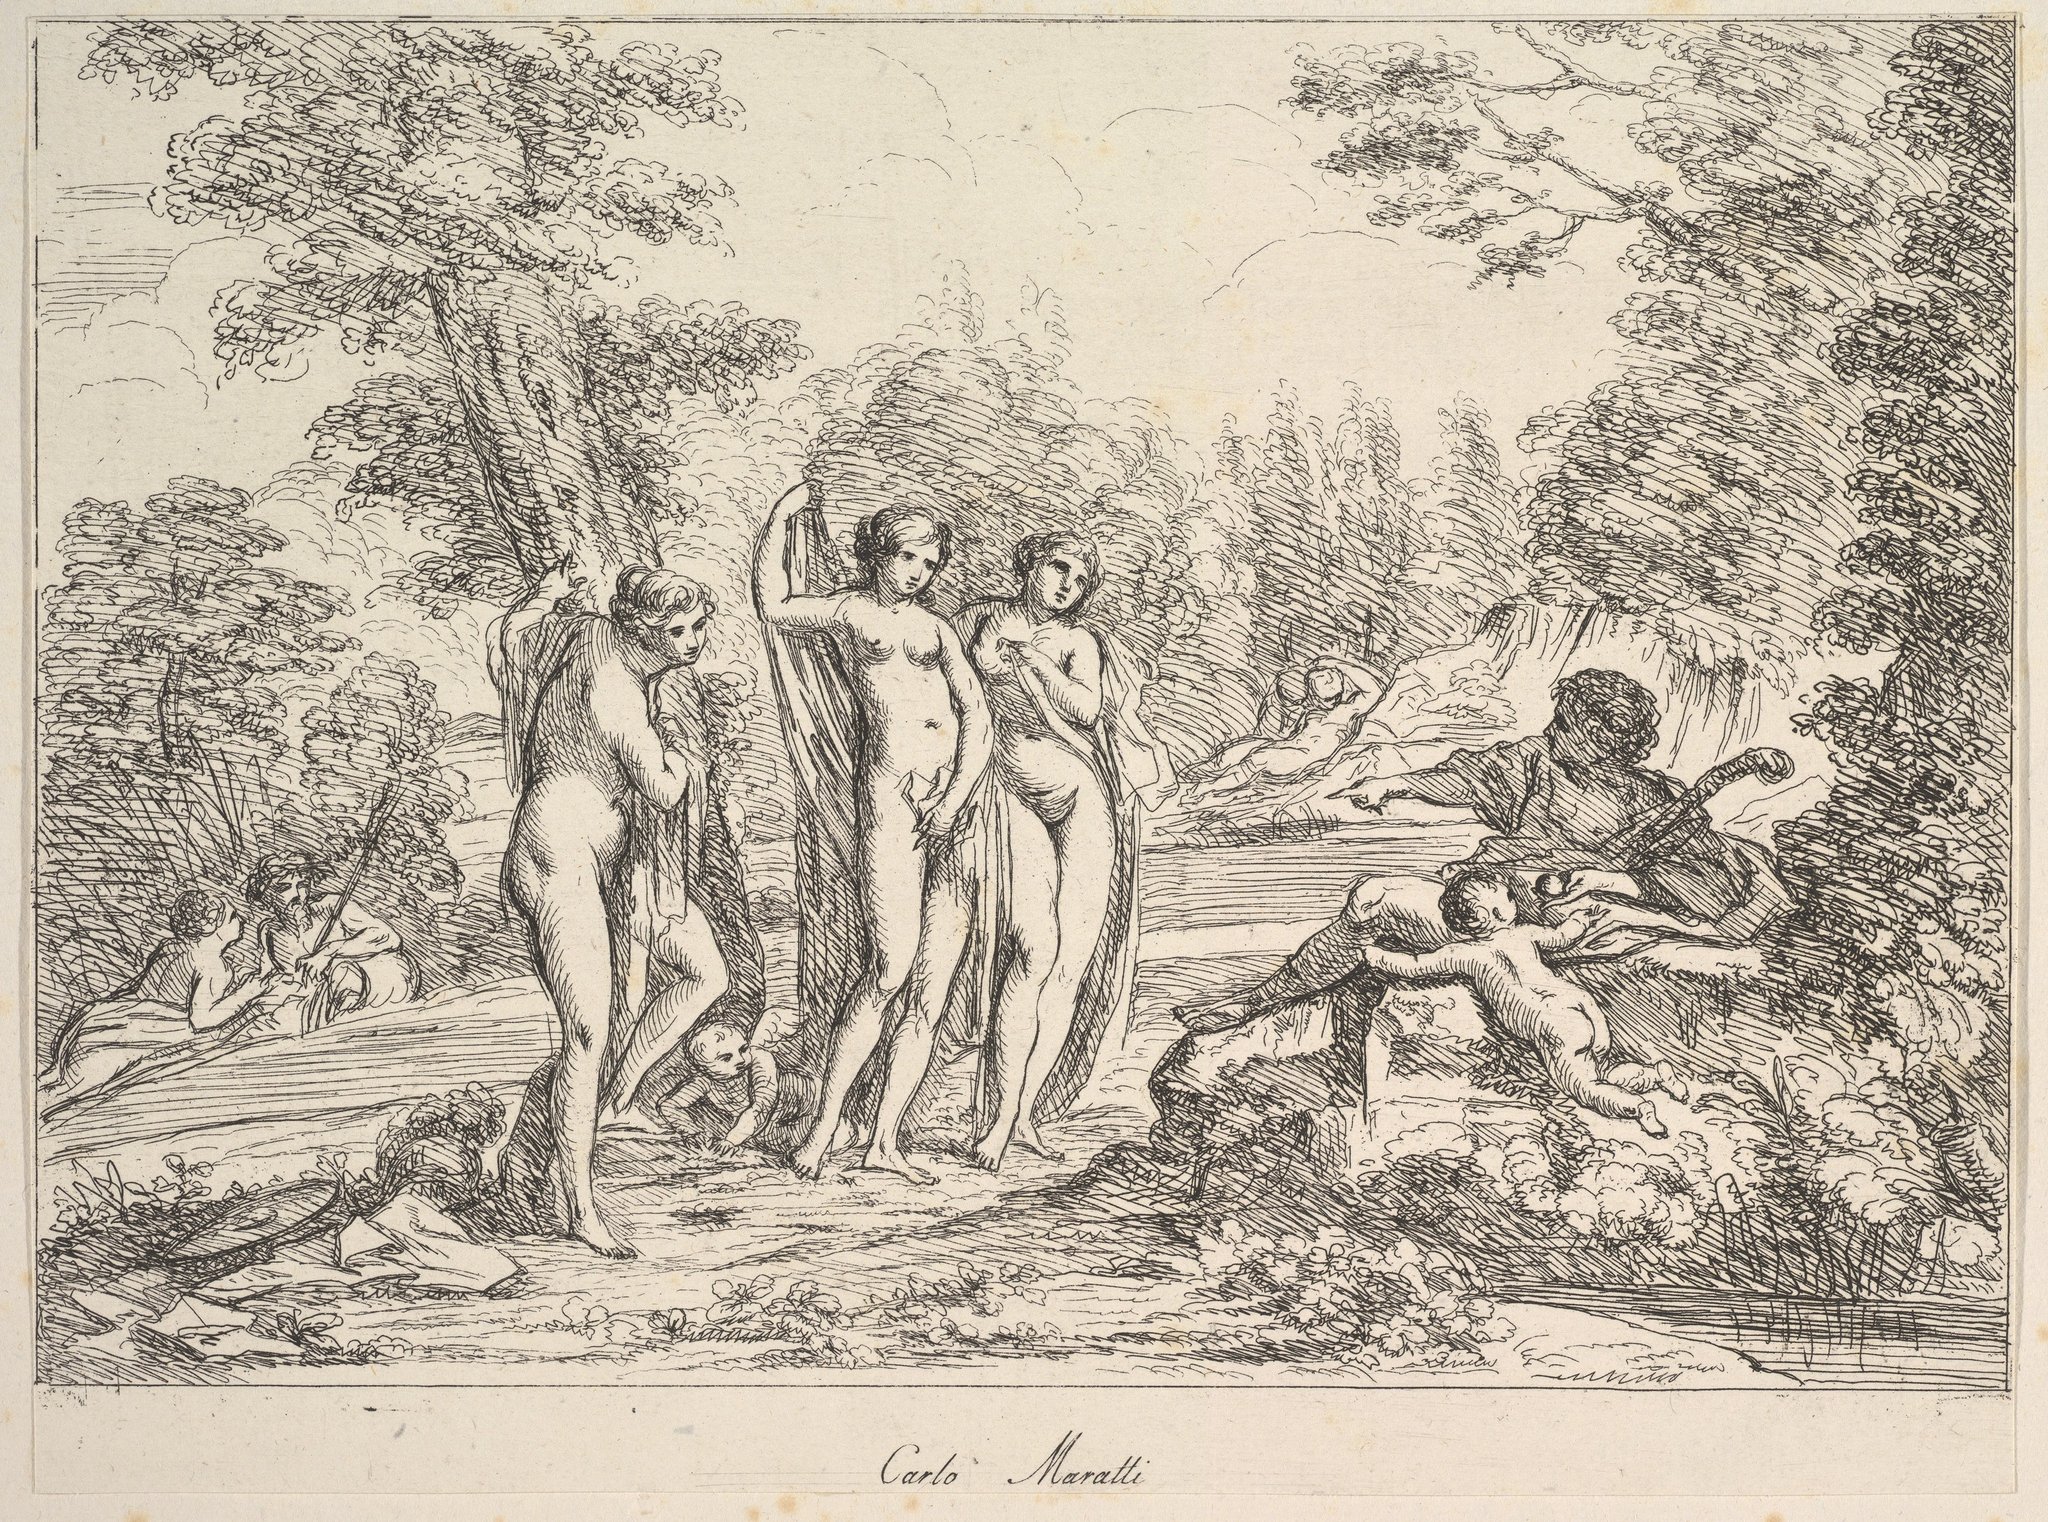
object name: print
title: The Judgement of Paris(?)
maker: giuseppe canale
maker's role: artist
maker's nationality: italian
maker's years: 1725-1802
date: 1740-1802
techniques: etching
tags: men,female nudes